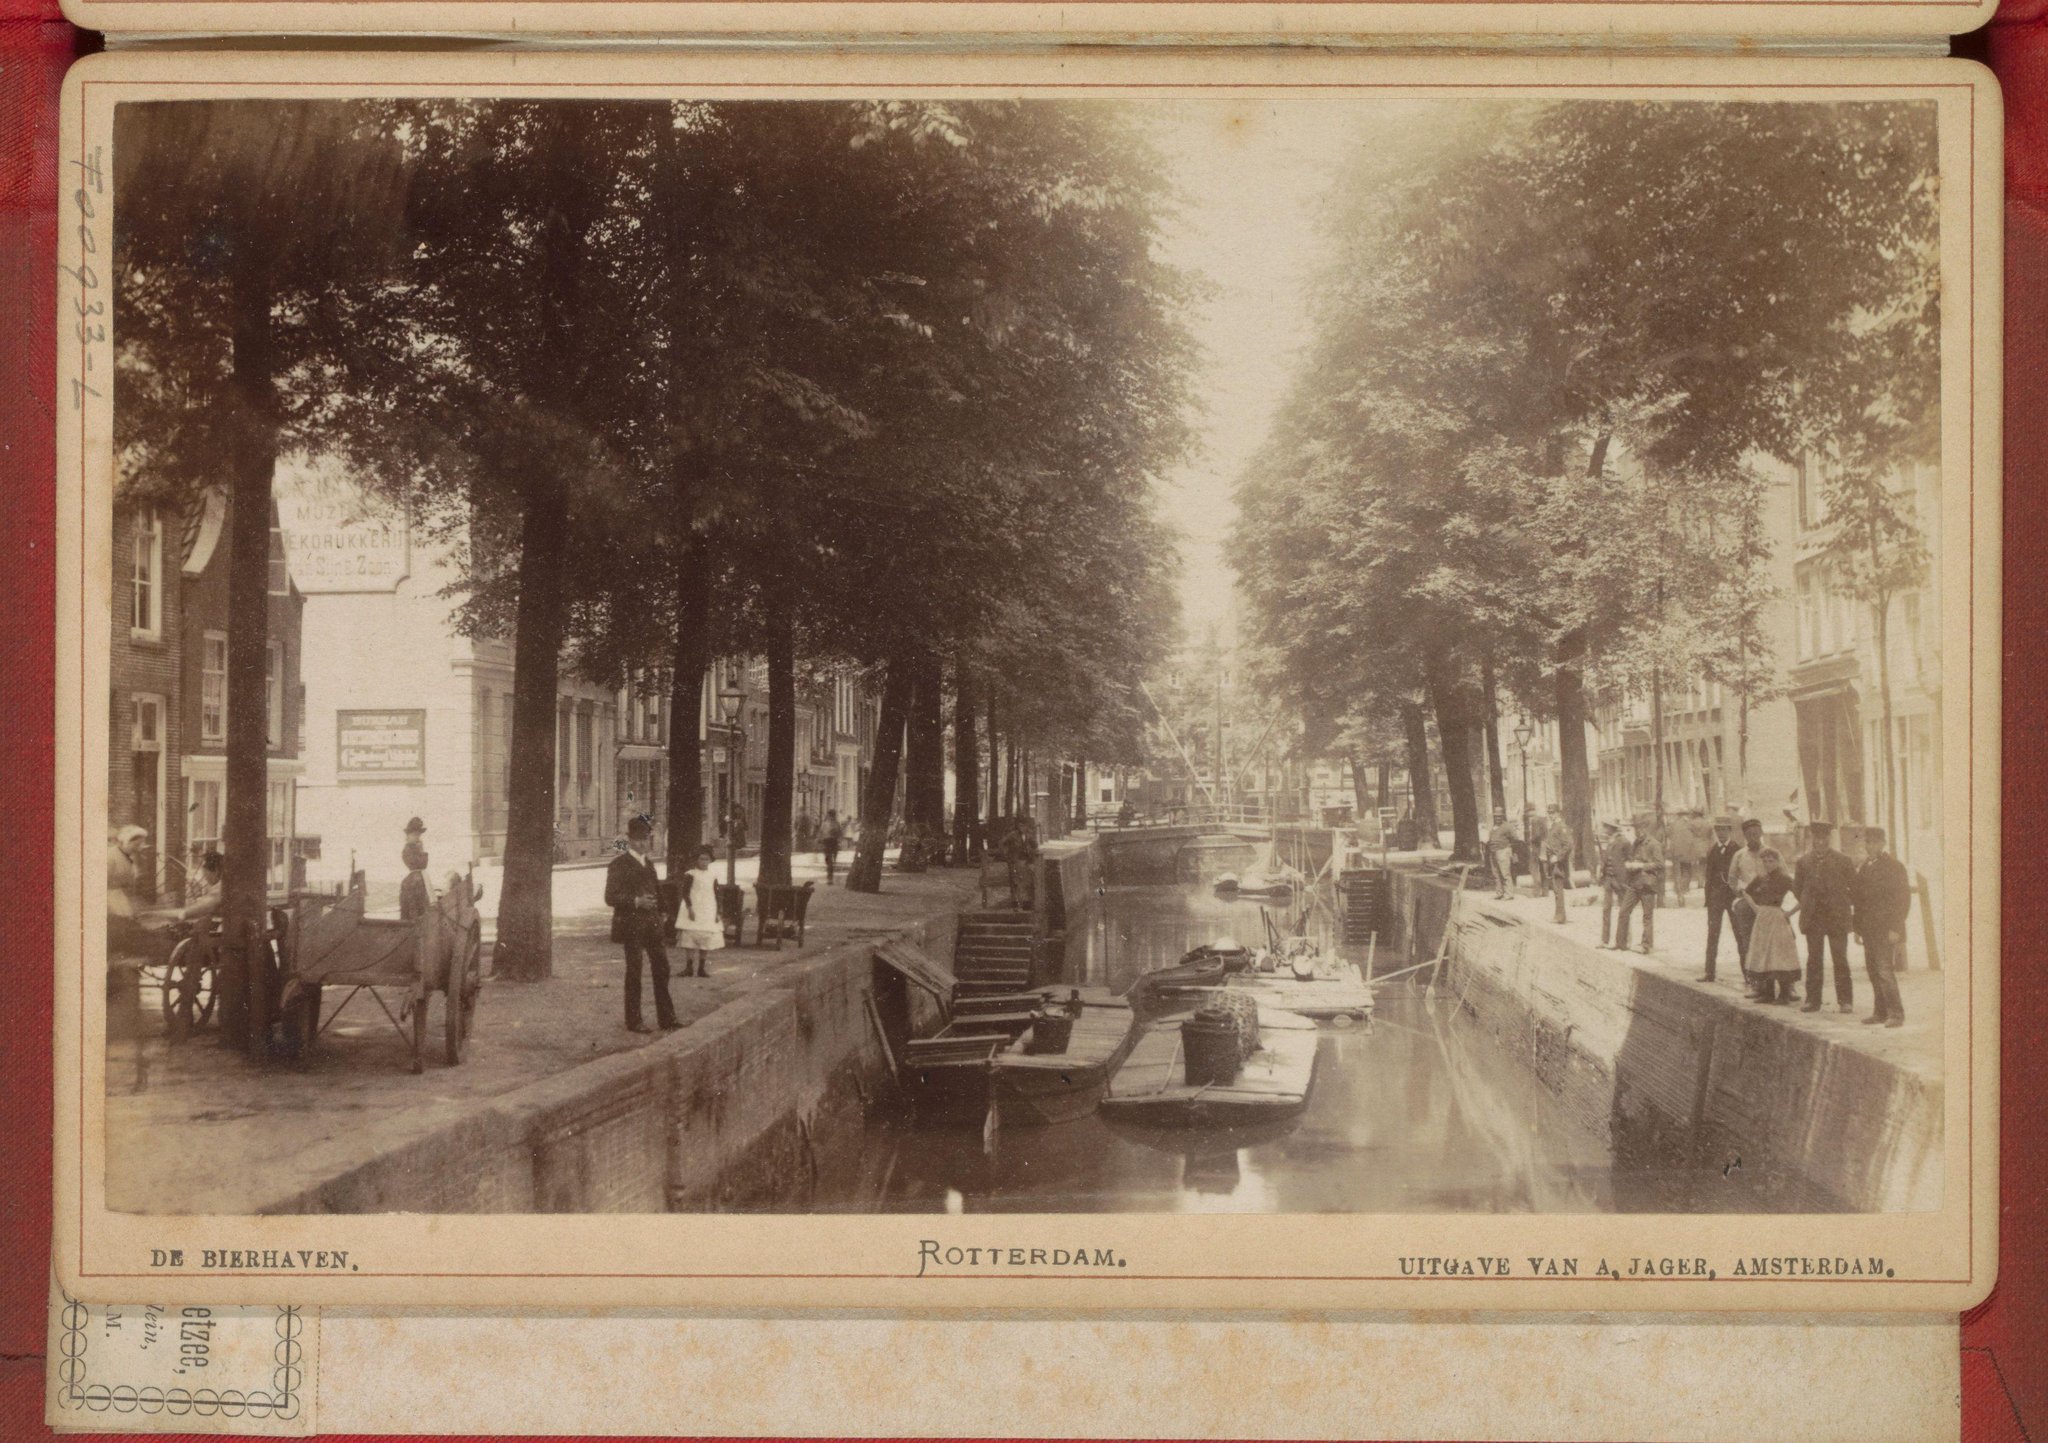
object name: photograph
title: De Bierhaven. Rotterdam.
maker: andries jager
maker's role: publisher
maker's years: 1825-1905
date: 1860-1900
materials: cardboard, photographic support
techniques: albumen print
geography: rotterdam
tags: harbour (+ view ~ vehicle, ship, etc.), canal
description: Onderdeel van Leporelloalbum met foto's van Rotterdam.